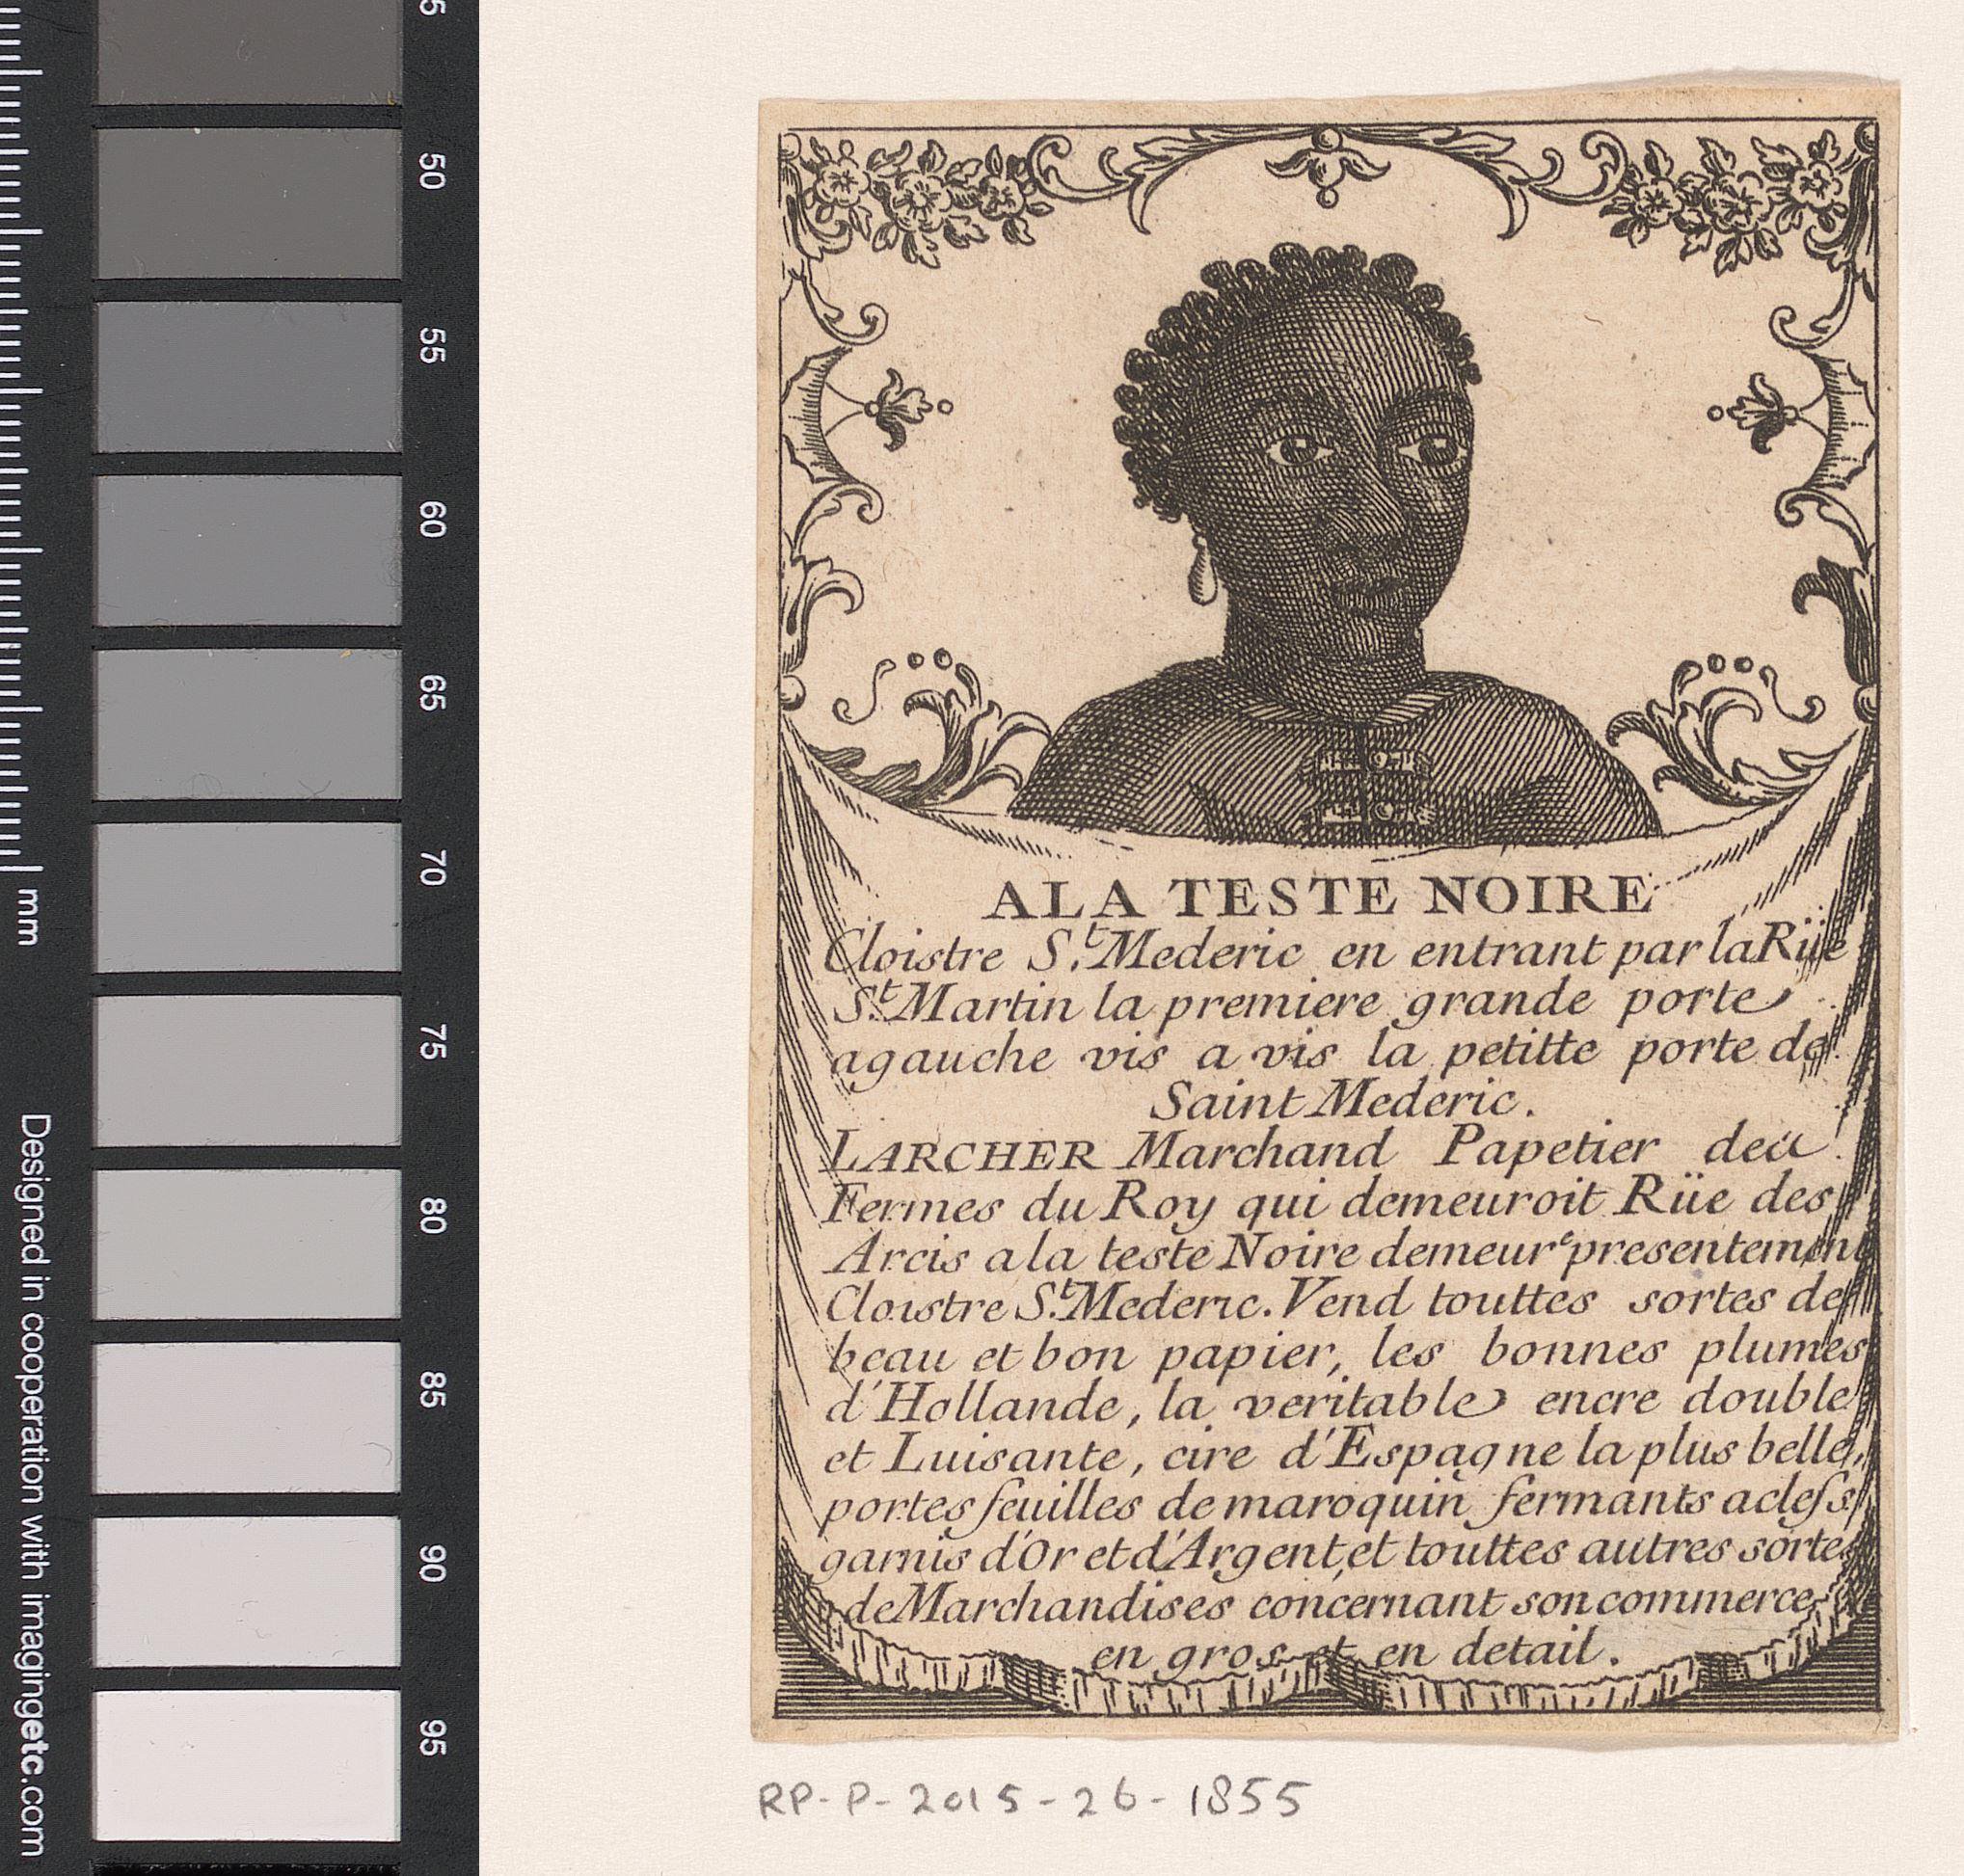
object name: print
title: A la teste noir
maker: Anonymous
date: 1720-1762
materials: paper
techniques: etching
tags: africans (+ women)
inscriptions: collector's mark: Lugt 4779, collector's mark: Lugt 2228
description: Gezicht van een zwarte man met een pareloorbel.